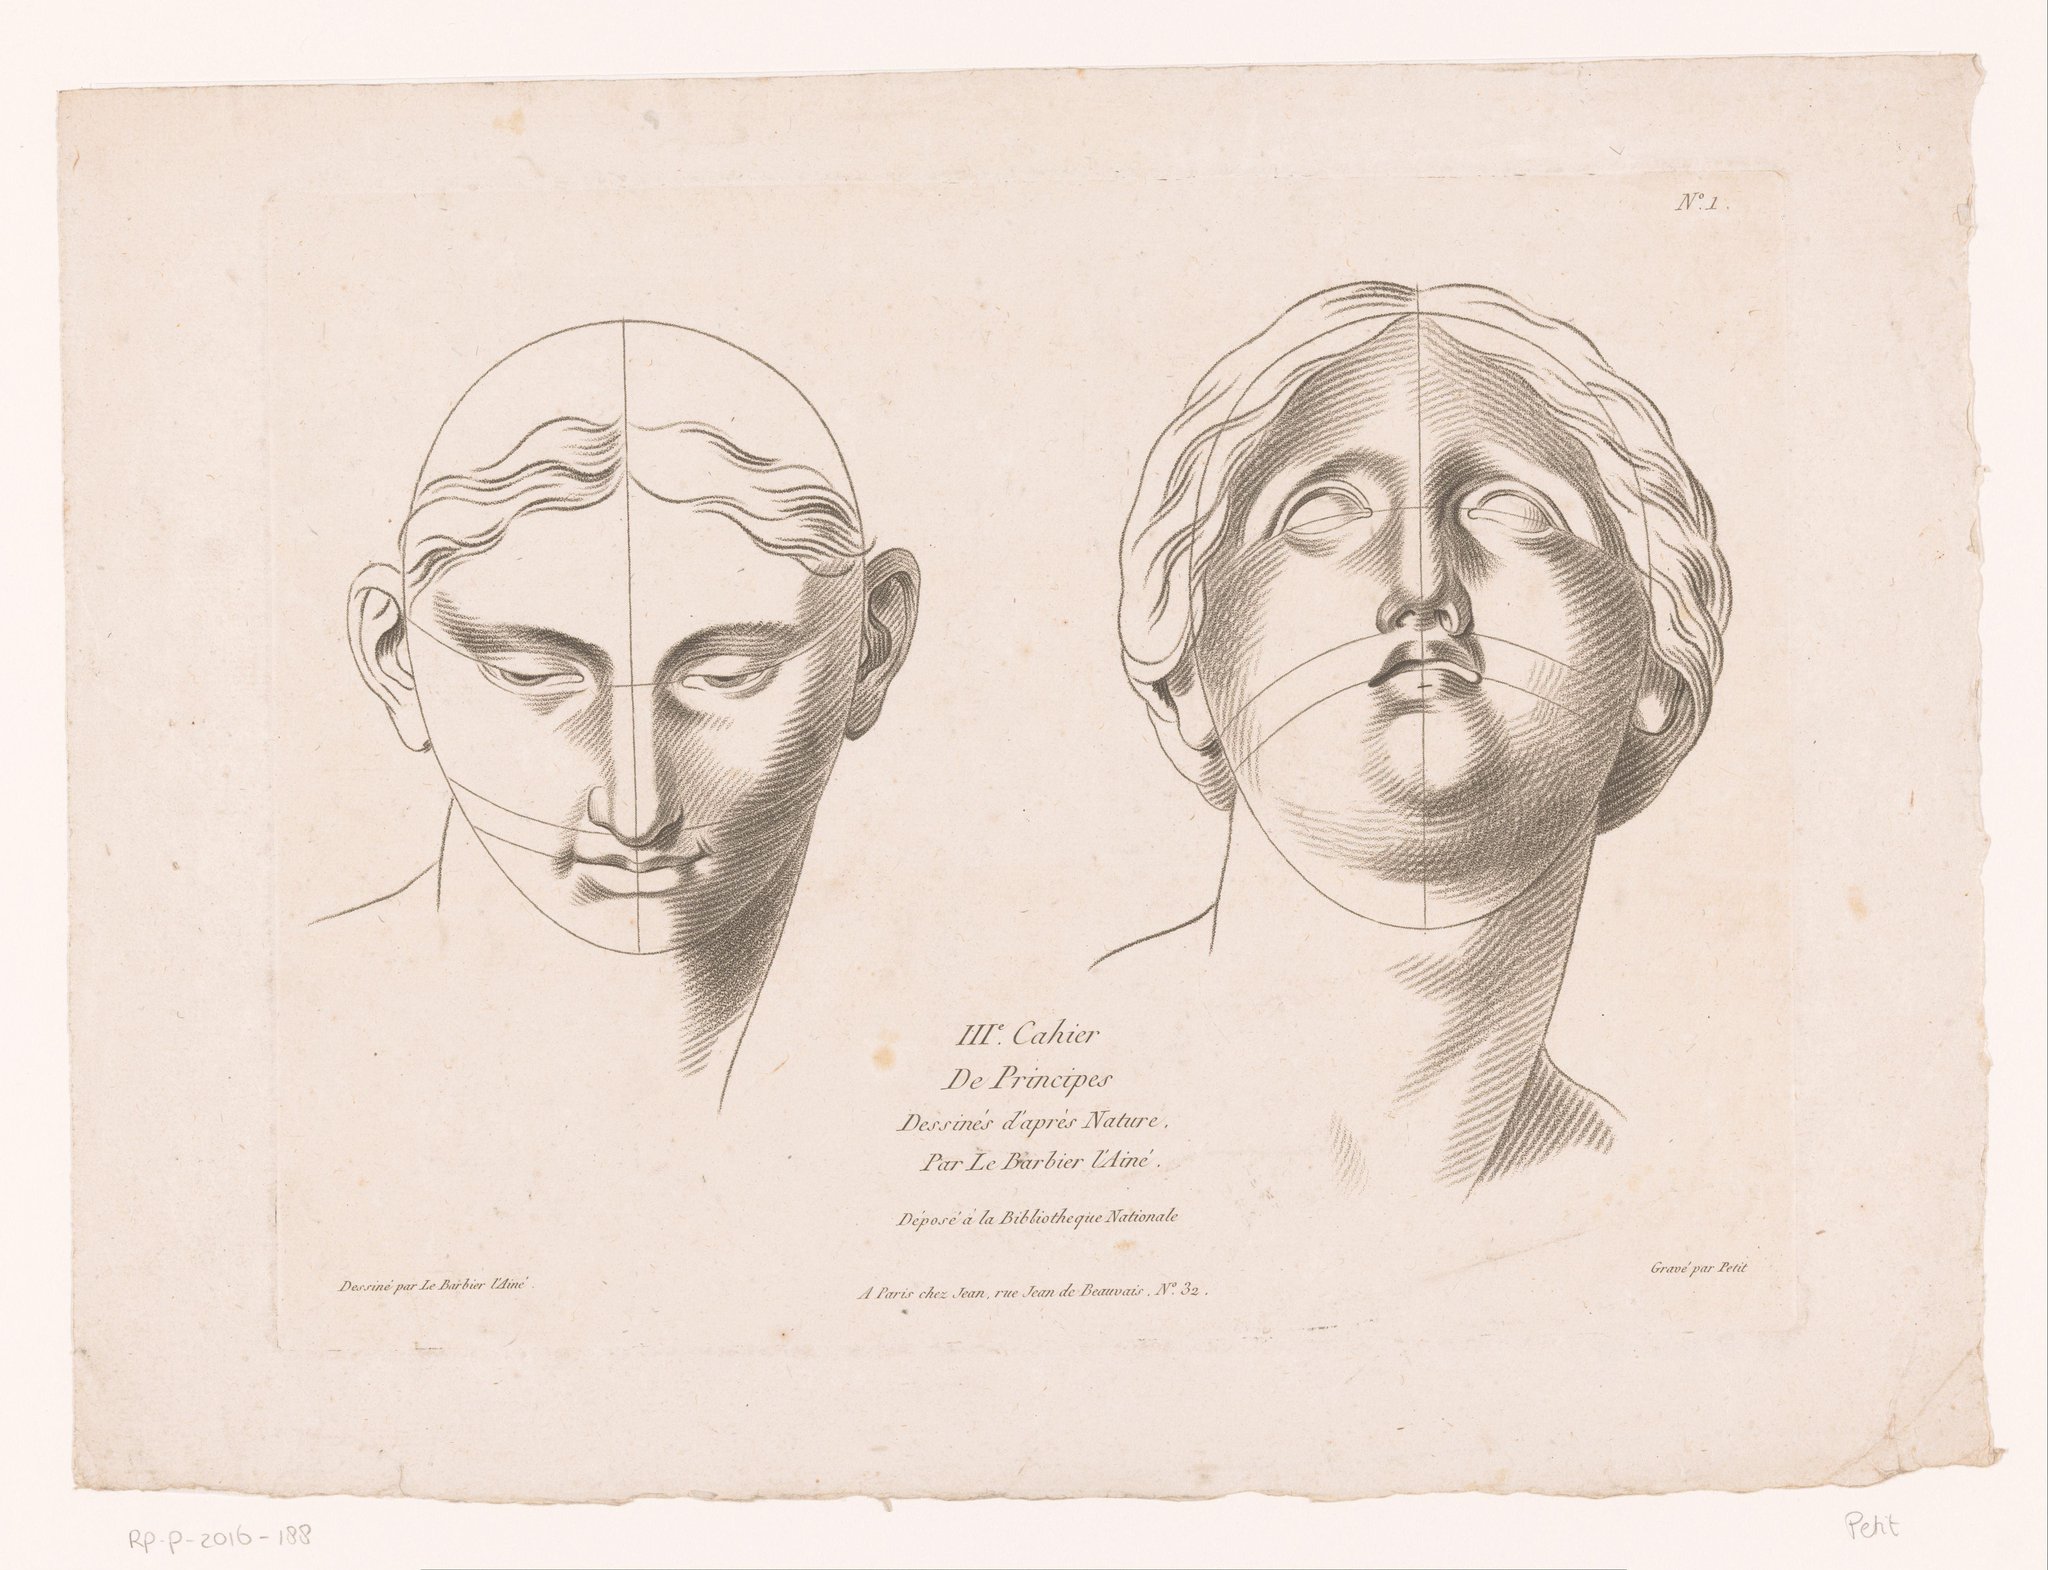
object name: print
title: Titelprent met twee vrouwenhoofden in schematische weergave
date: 1784-1826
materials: paper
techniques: printmaking, etching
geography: paris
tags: drawing, sketch, head (human) - aa - female human figure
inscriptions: : ‘Déposé à la Bibliothèque Nationale’, collector's mark: Lugt 2228